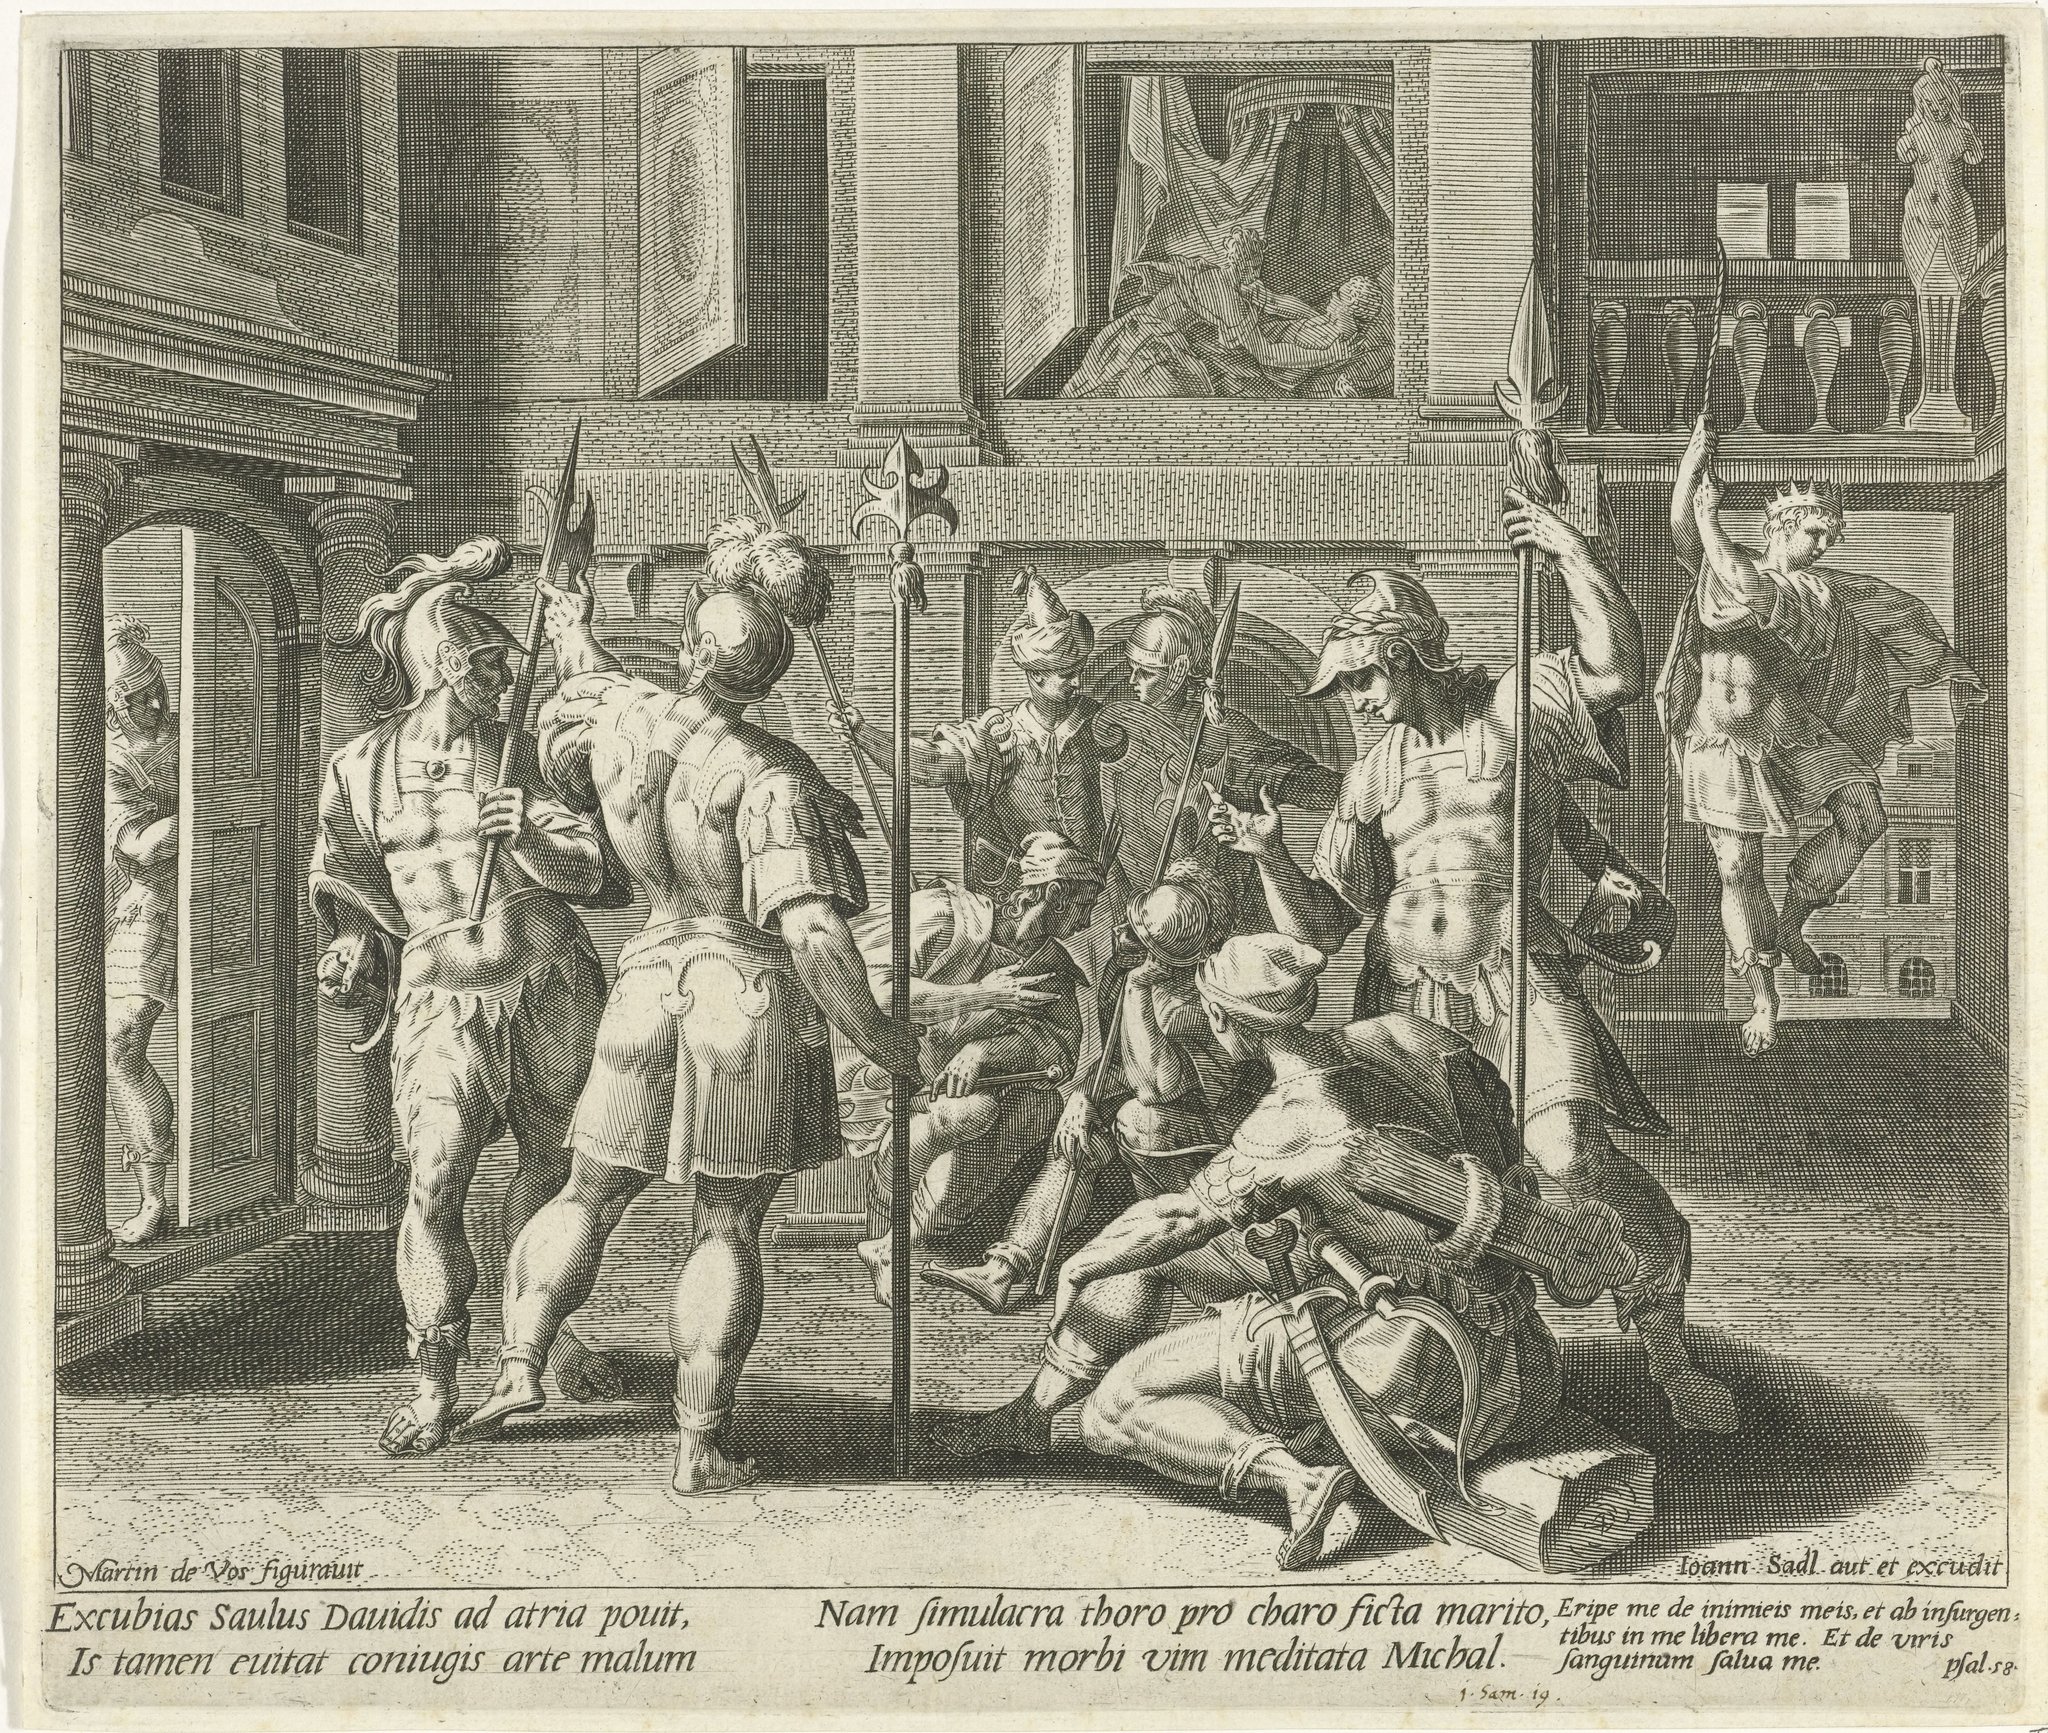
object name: print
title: Michal helpt David ontsnappen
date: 1580-1596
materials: paper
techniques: engraving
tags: david escapes through a window; michal lets him down with the help of a rope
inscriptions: inscription: ‘1 Sam. 19’, collector's mark: Lugt 11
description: Op de voorgrond de soldaten van Saul die David komen arresteren. Op de achtergrond de slaapkamer van Michal, de dochter van Saul. Zij helpt David met een touw via het balkon te ontsnappen. De prent heeft een Latijns onderschrift met uitleg en rechts in de hoek een vers uit psalm 58.